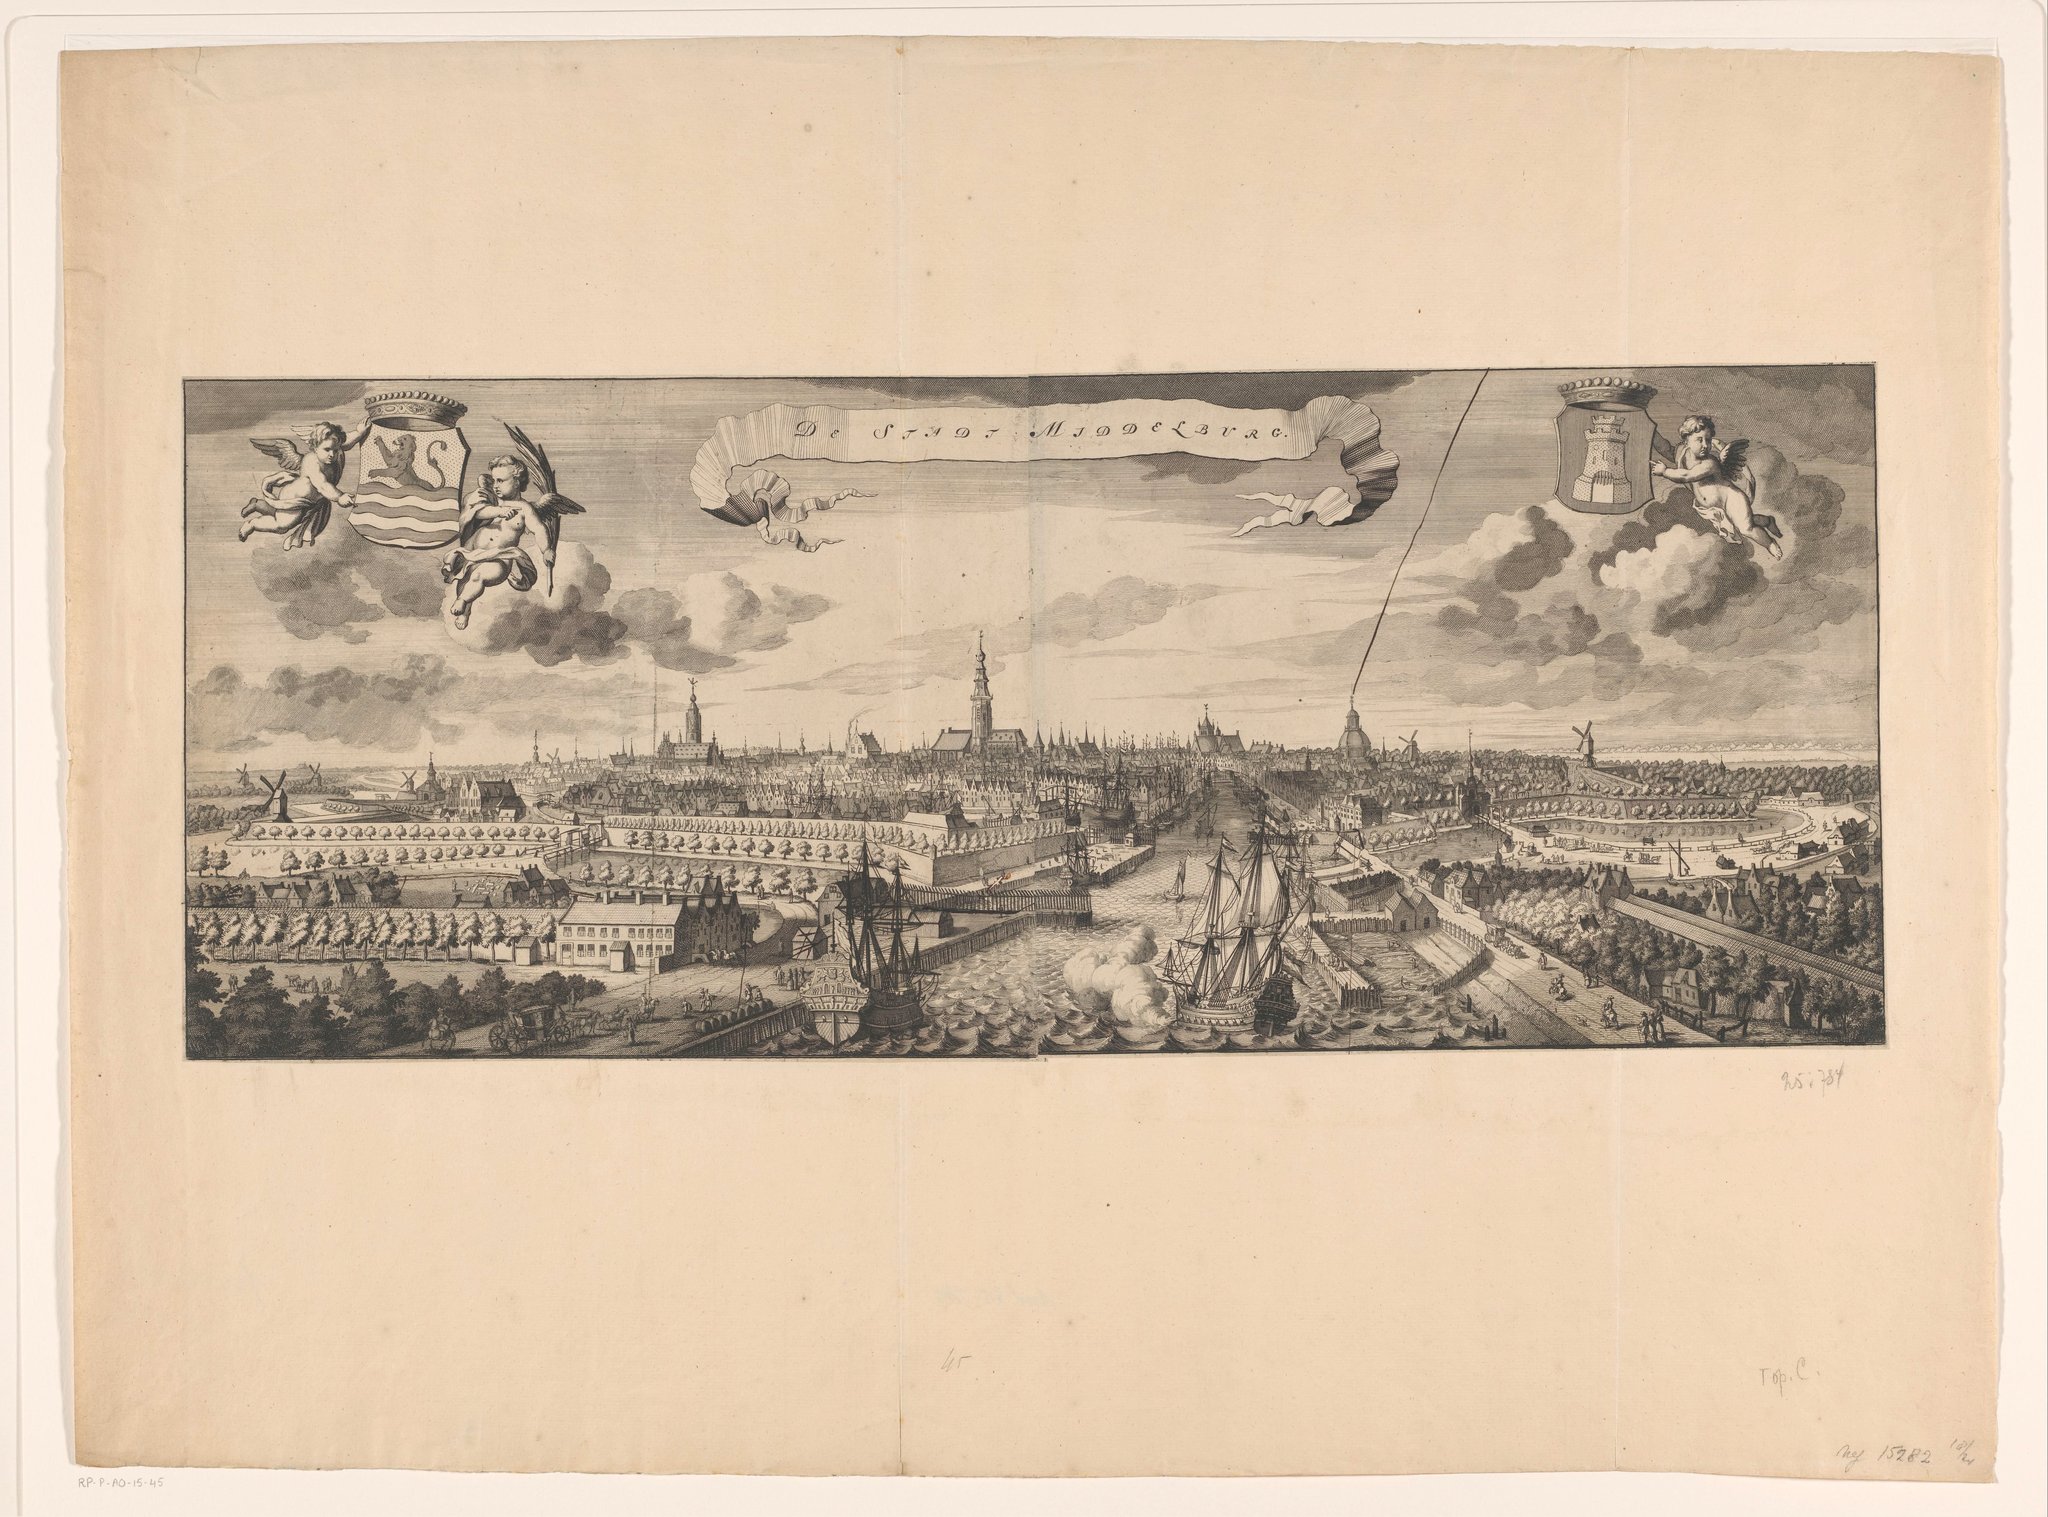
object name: book illustration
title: De stadt Middelburg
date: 1696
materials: paper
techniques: engraving, etching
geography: amsterdam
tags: coat of arms (as symbol of the state, etc.) (+ city; municipal), coat of arms (as symbol of the state, etc.) (+ province; provincial), prospect of city, town panorama, silhouette of city, middelburg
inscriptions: collector's mark: Lugt 195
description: Huidige staat van prent ook gebruikt in: Smallegange, Mattheus. Nieuwe Cronyk van Zeeland (…). Middelburg en Amsterdam: Johannes Meertens en Abraham van Someren, 1696. Latere staat van prent (zonder nummering rechtsboven) ook gebruikt in: Aa, Pieter van der. La galerie agreable du monde (...). 66 delen. Leiden: Pieter van der Aa, 1728, dl. 20.